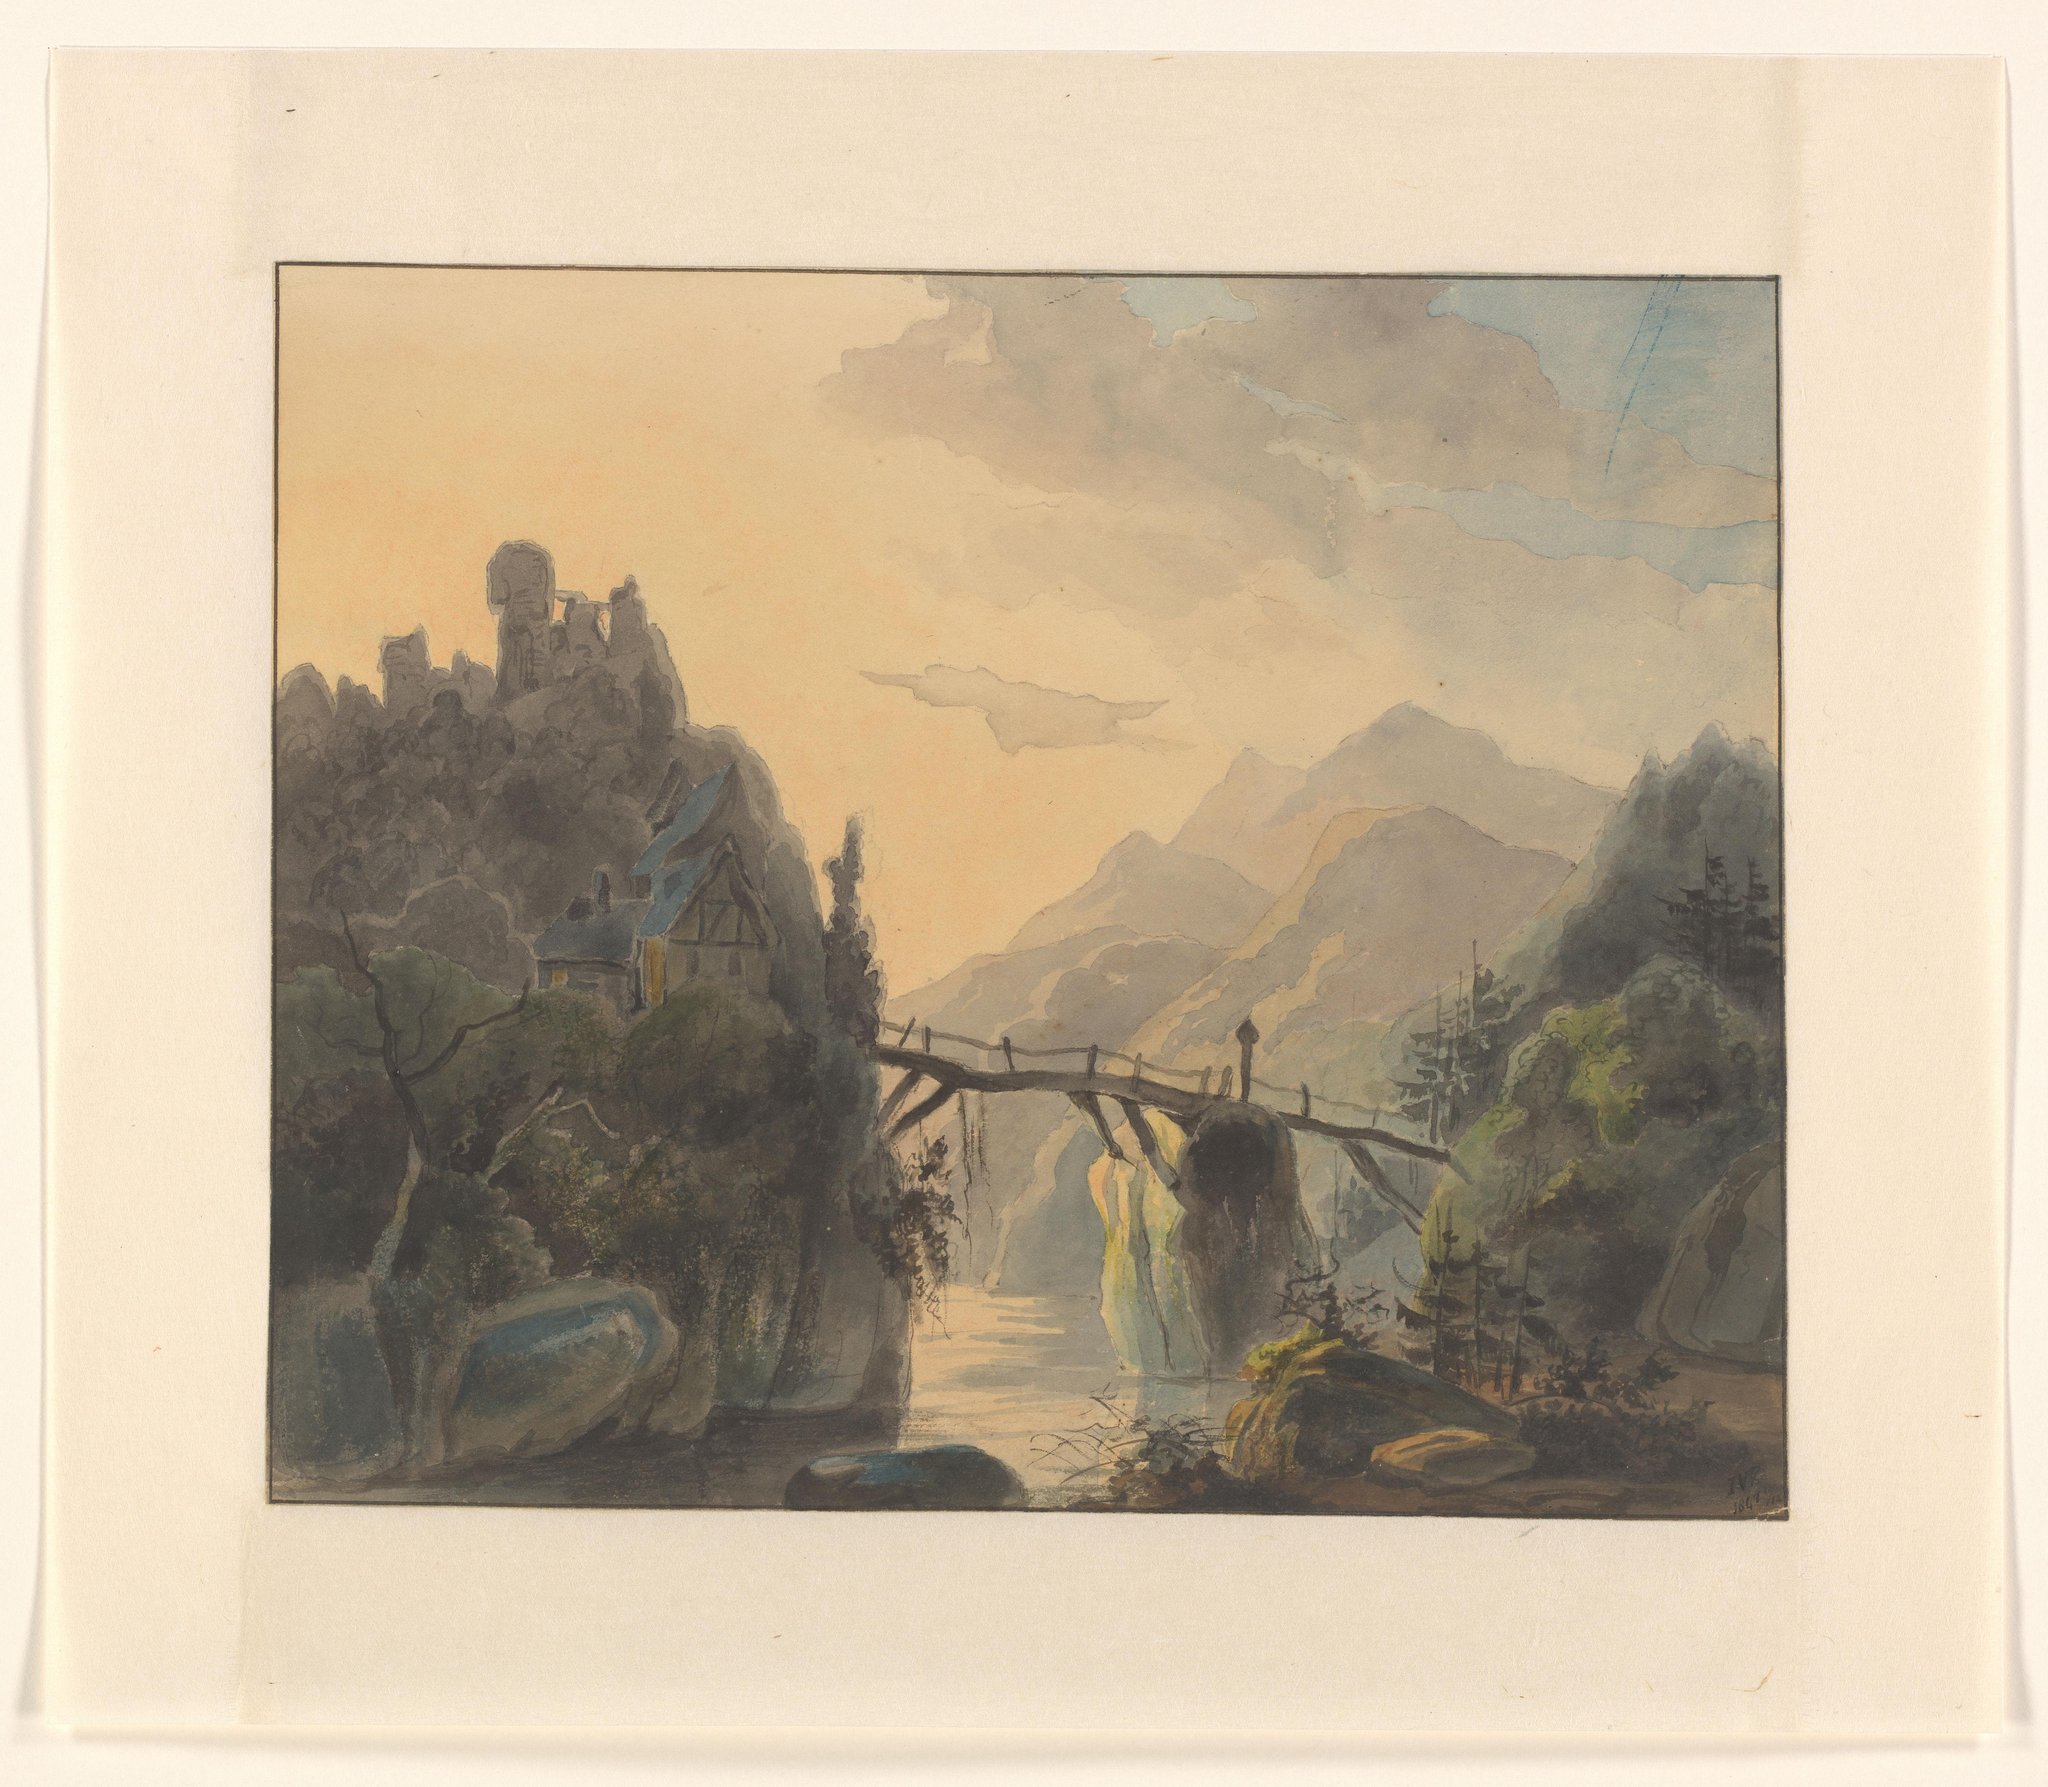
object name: drawing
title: Berglandschap met houten brug over een rivier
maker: johannes van reijn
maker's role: draughtsman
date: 1847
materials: paper, pencil, watercolor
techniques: brush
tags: landscape with bridge, viaduct or aqueduct, mountains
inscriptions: date